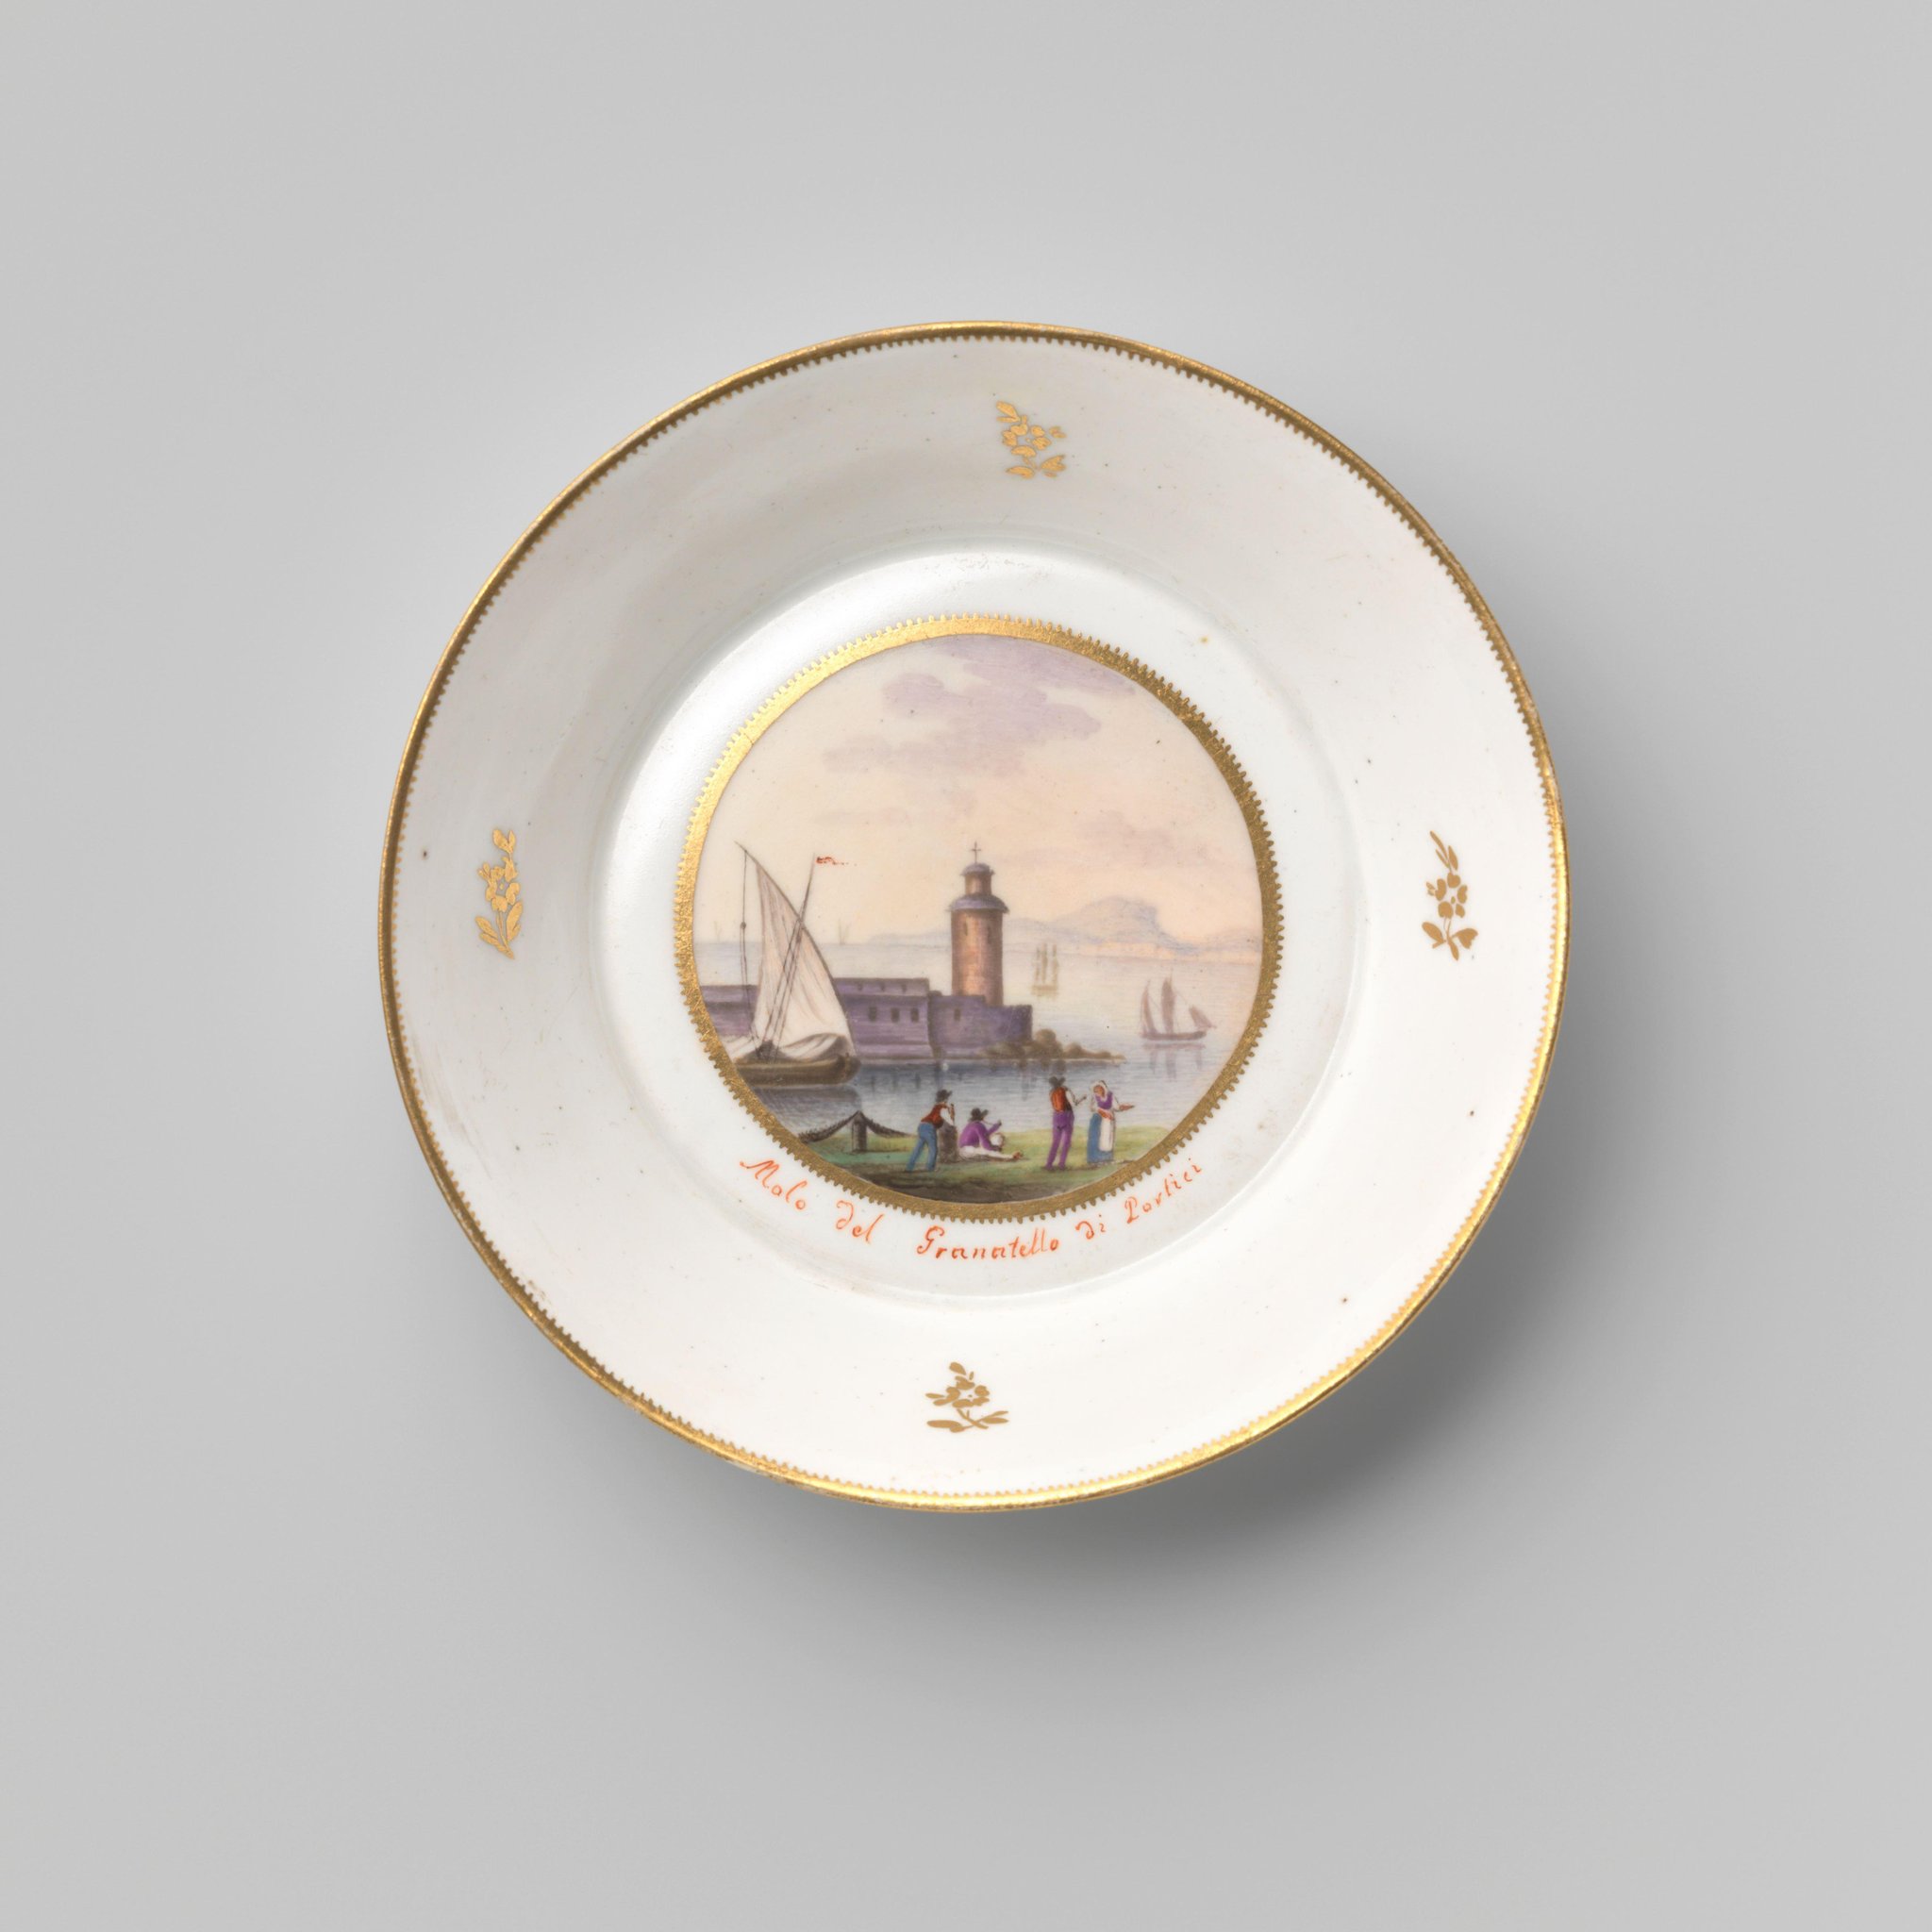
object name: platter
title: Saucer with a port scene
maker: Anonymous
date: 1775-1799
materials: glaze, gold, paint, porcelain, soft paste porcelain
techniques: firing, gilding, turning, vitrification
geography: naples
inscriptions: inscription: ‘MOLO DEL GRANATELLO DI PORTIERI’, mark: ‘gekroonde N’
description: Schotel van soft-paste porselein (pâte tendre), beschilderd op het glazuur in emailkleuren en goud. Op het plat een medaillon met een havengezicht met op de voorgrond een aantal personen. Onder het medaillon het opschrift 'MOLO DEL GRANATELLO DI PORTIERI'. De binnenwand met viermaal een bloemtak en een gouden rand. Gemerkt op de onderzijde met de gekroonde N.